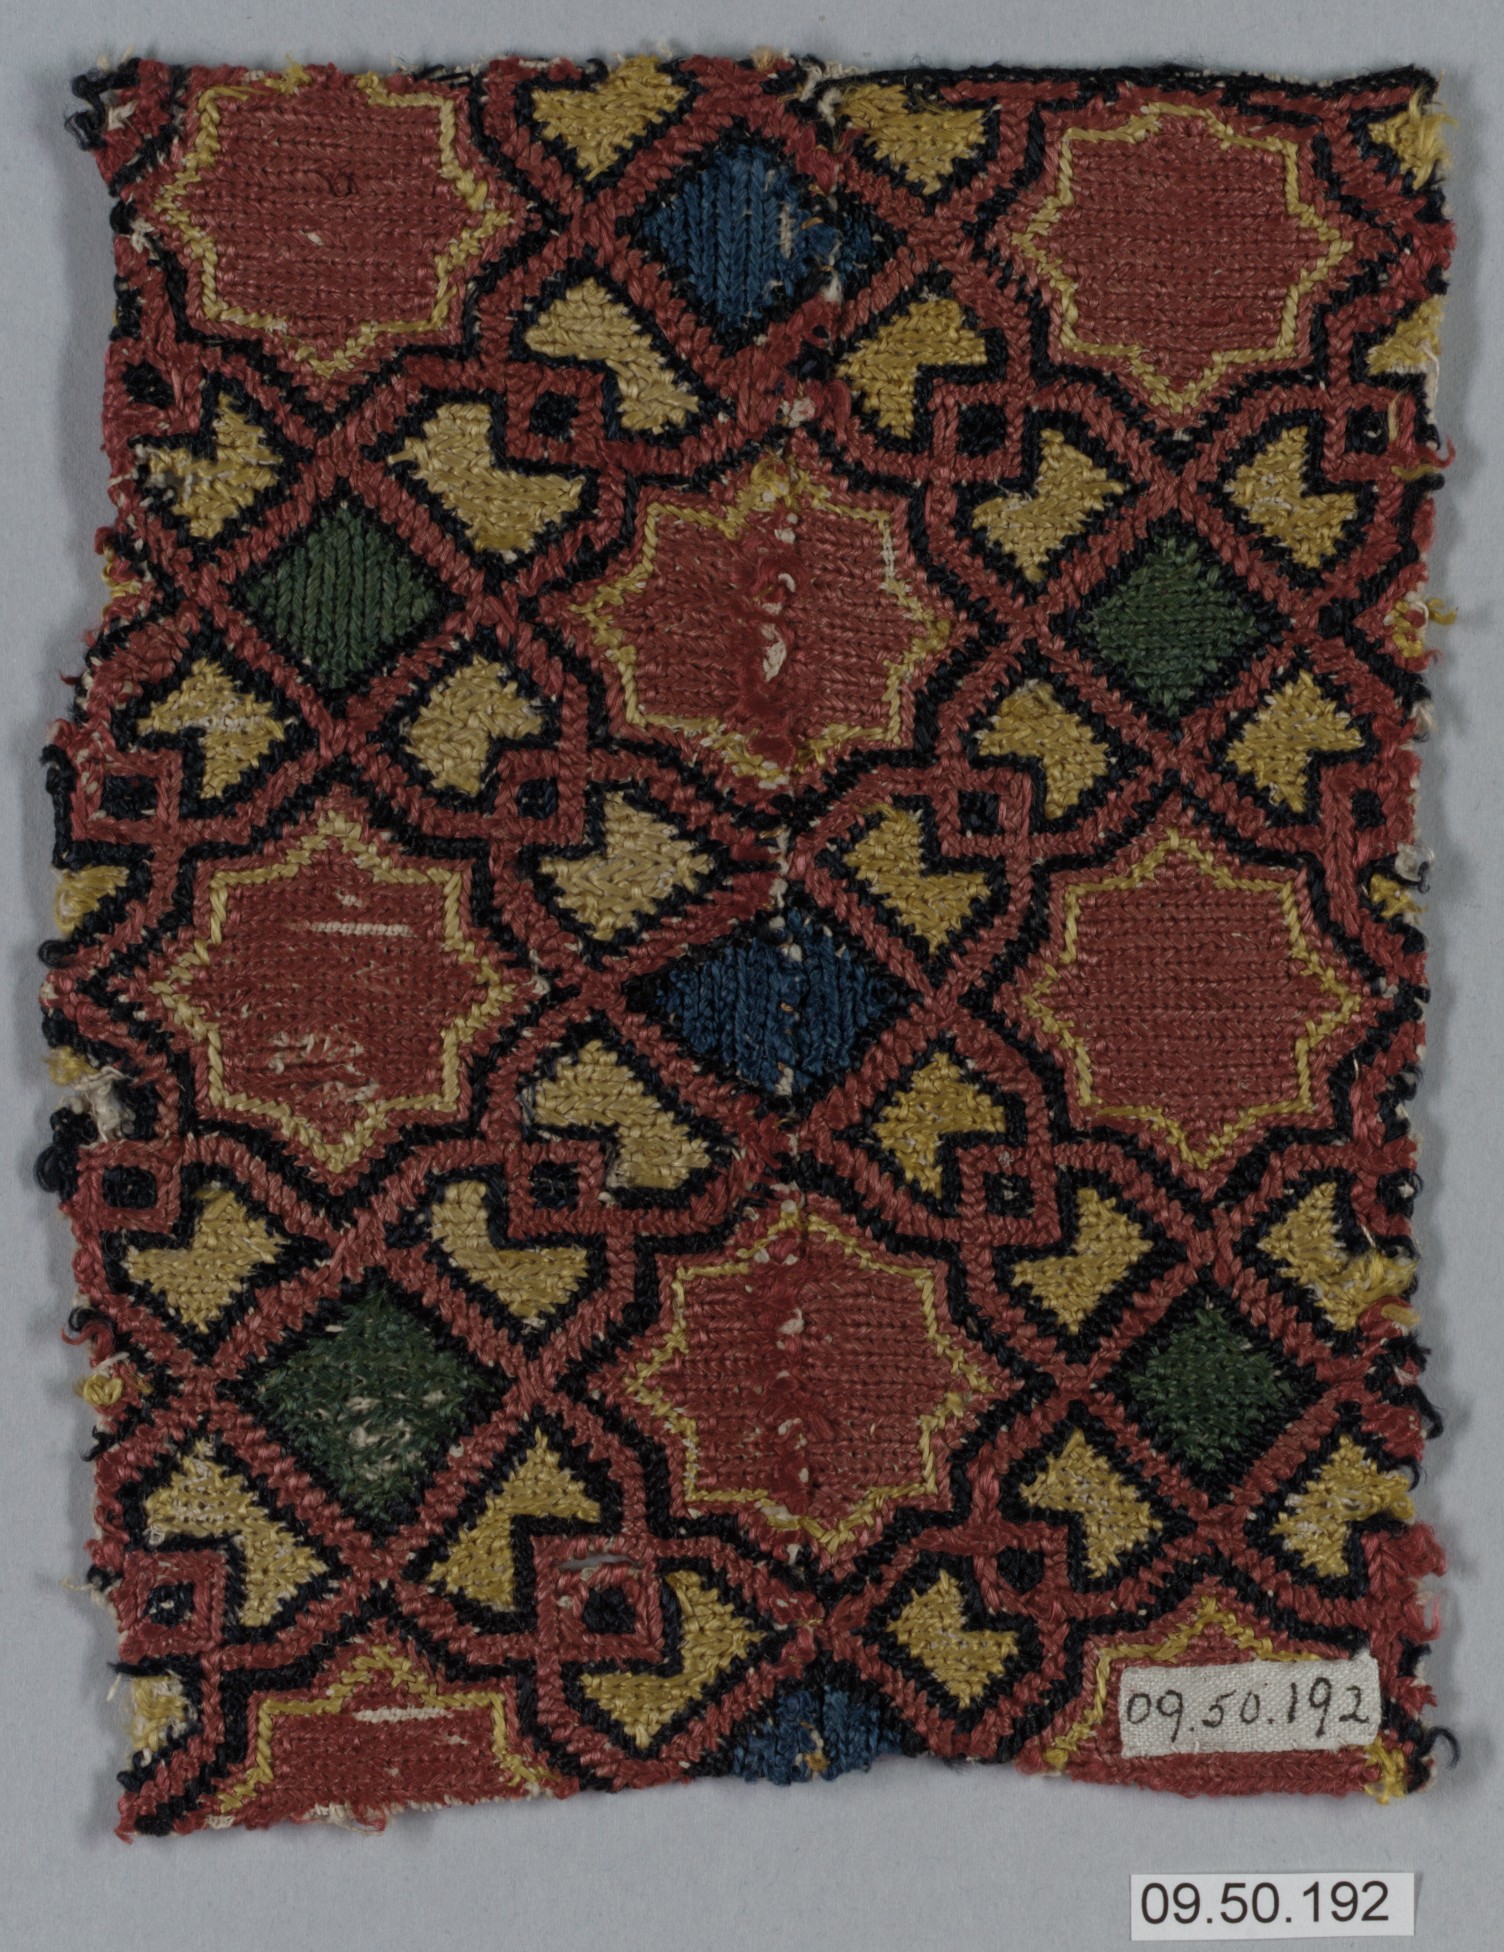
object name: textile fragment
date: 1701-1900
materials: linen, silk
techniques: embroidery, weave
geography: morocco